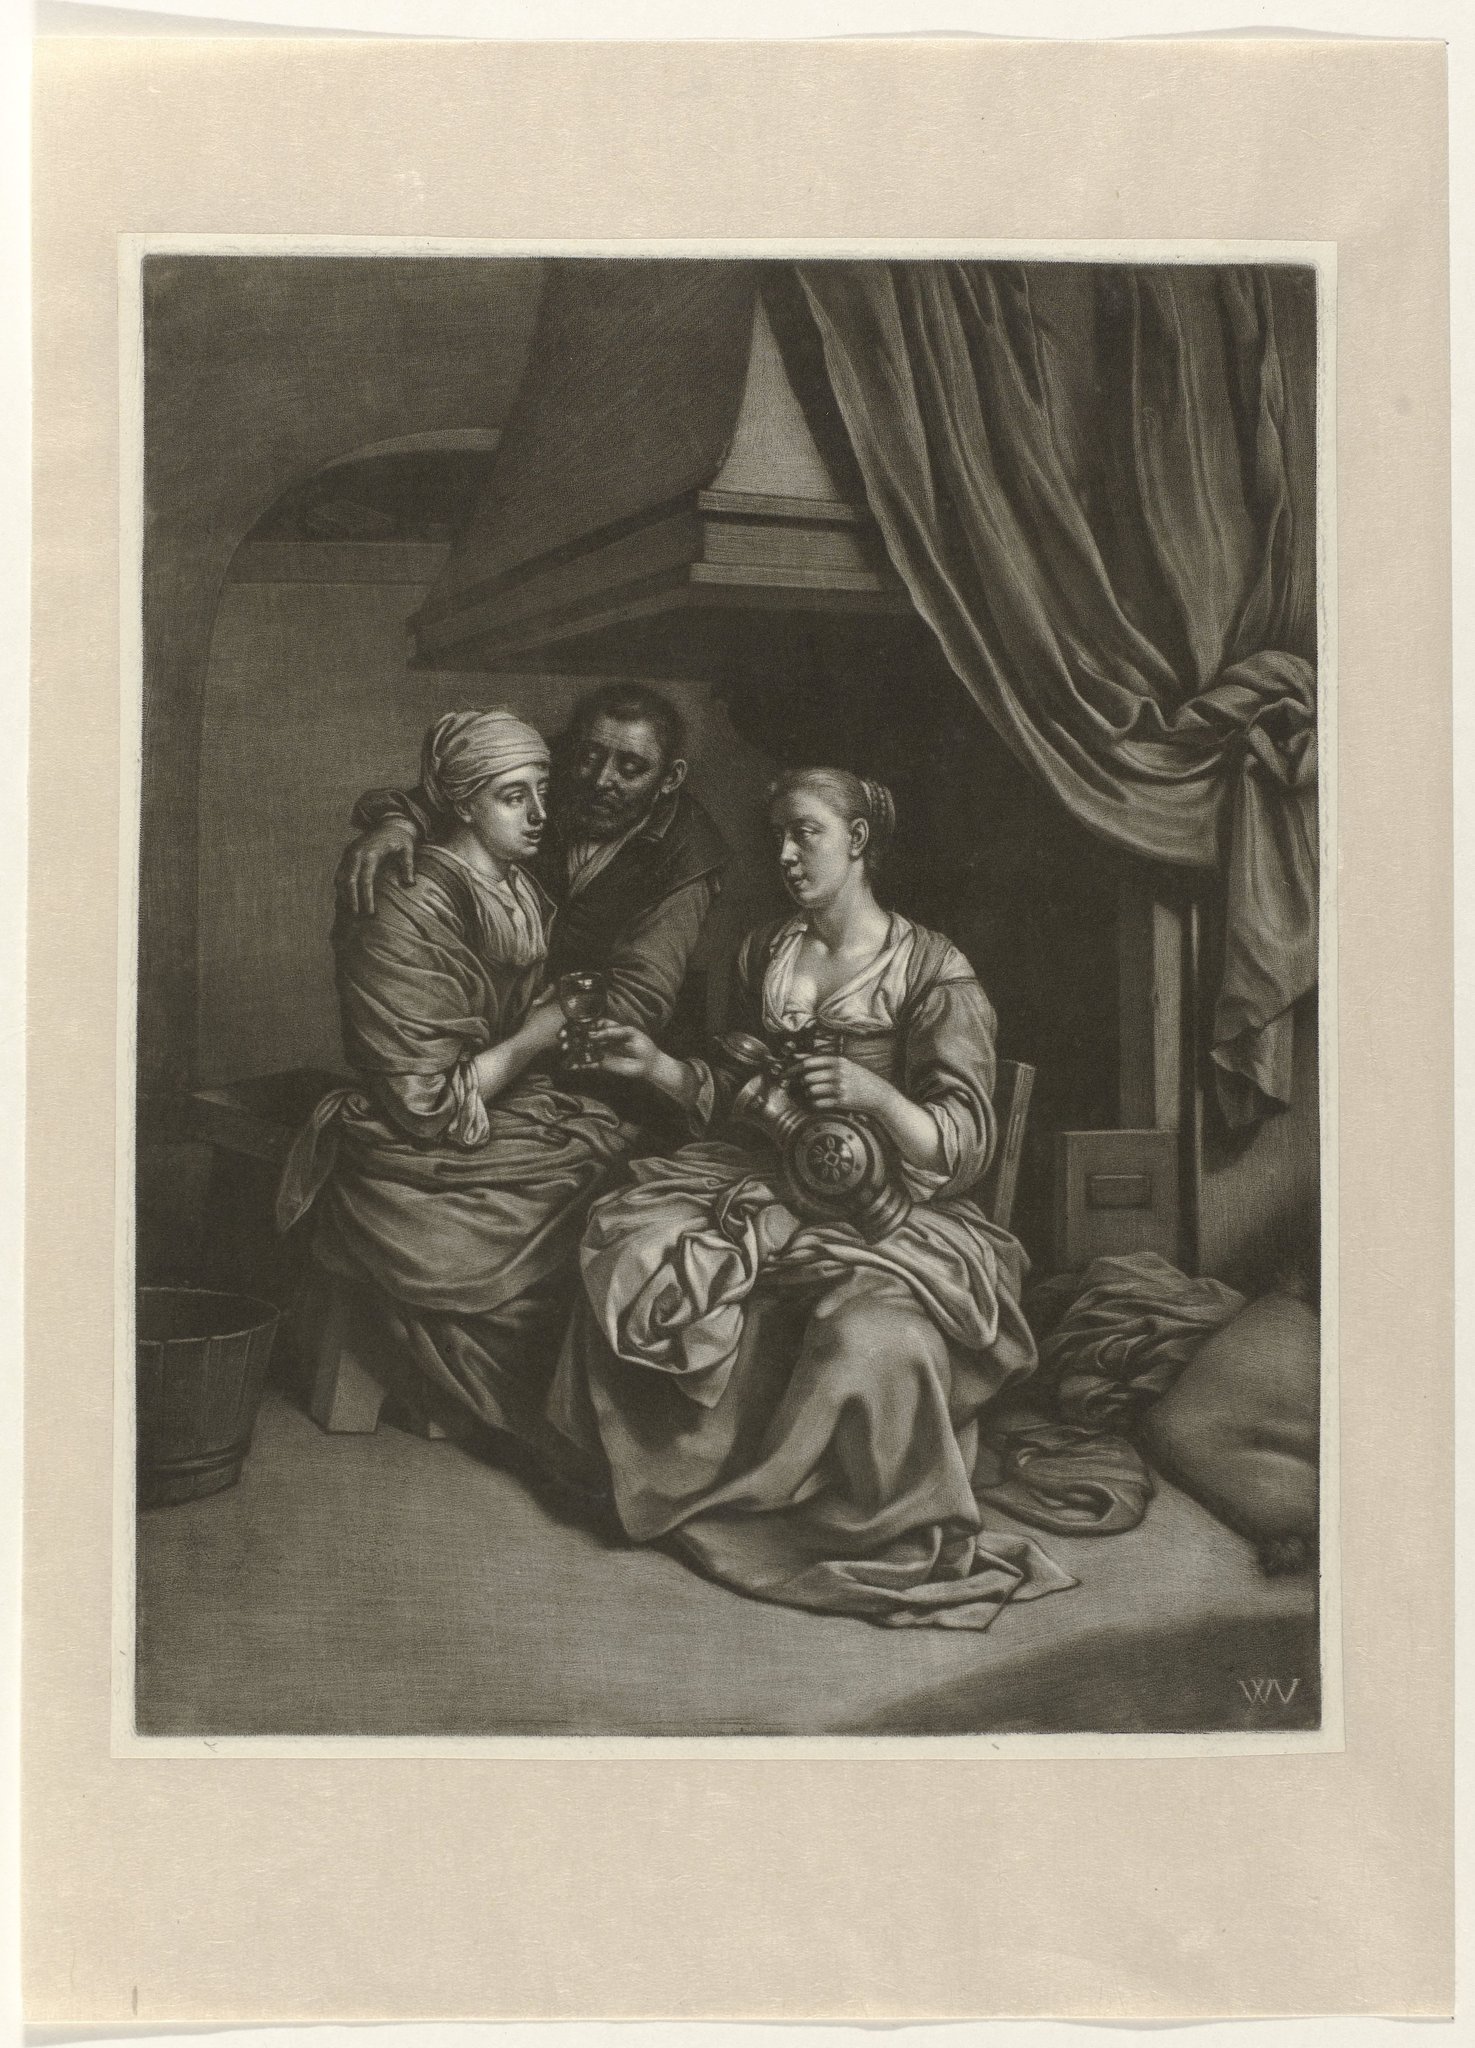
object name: print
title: Vrouwen en een man bij de haard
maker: wallerant vaillant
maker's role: draughtsman, painter, print maker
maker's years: 1623-1677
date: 1658-1677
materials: paper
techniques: mezzotint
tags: open hearth, fire-place, drinking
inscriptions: collector's mark: Lugt 10, collector's mark: Lugt 11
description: Een man en een vrouw zitten in een omhelzing bij de haard. Een tweede vrouw schenkt hen een glas drank in uit een kan.